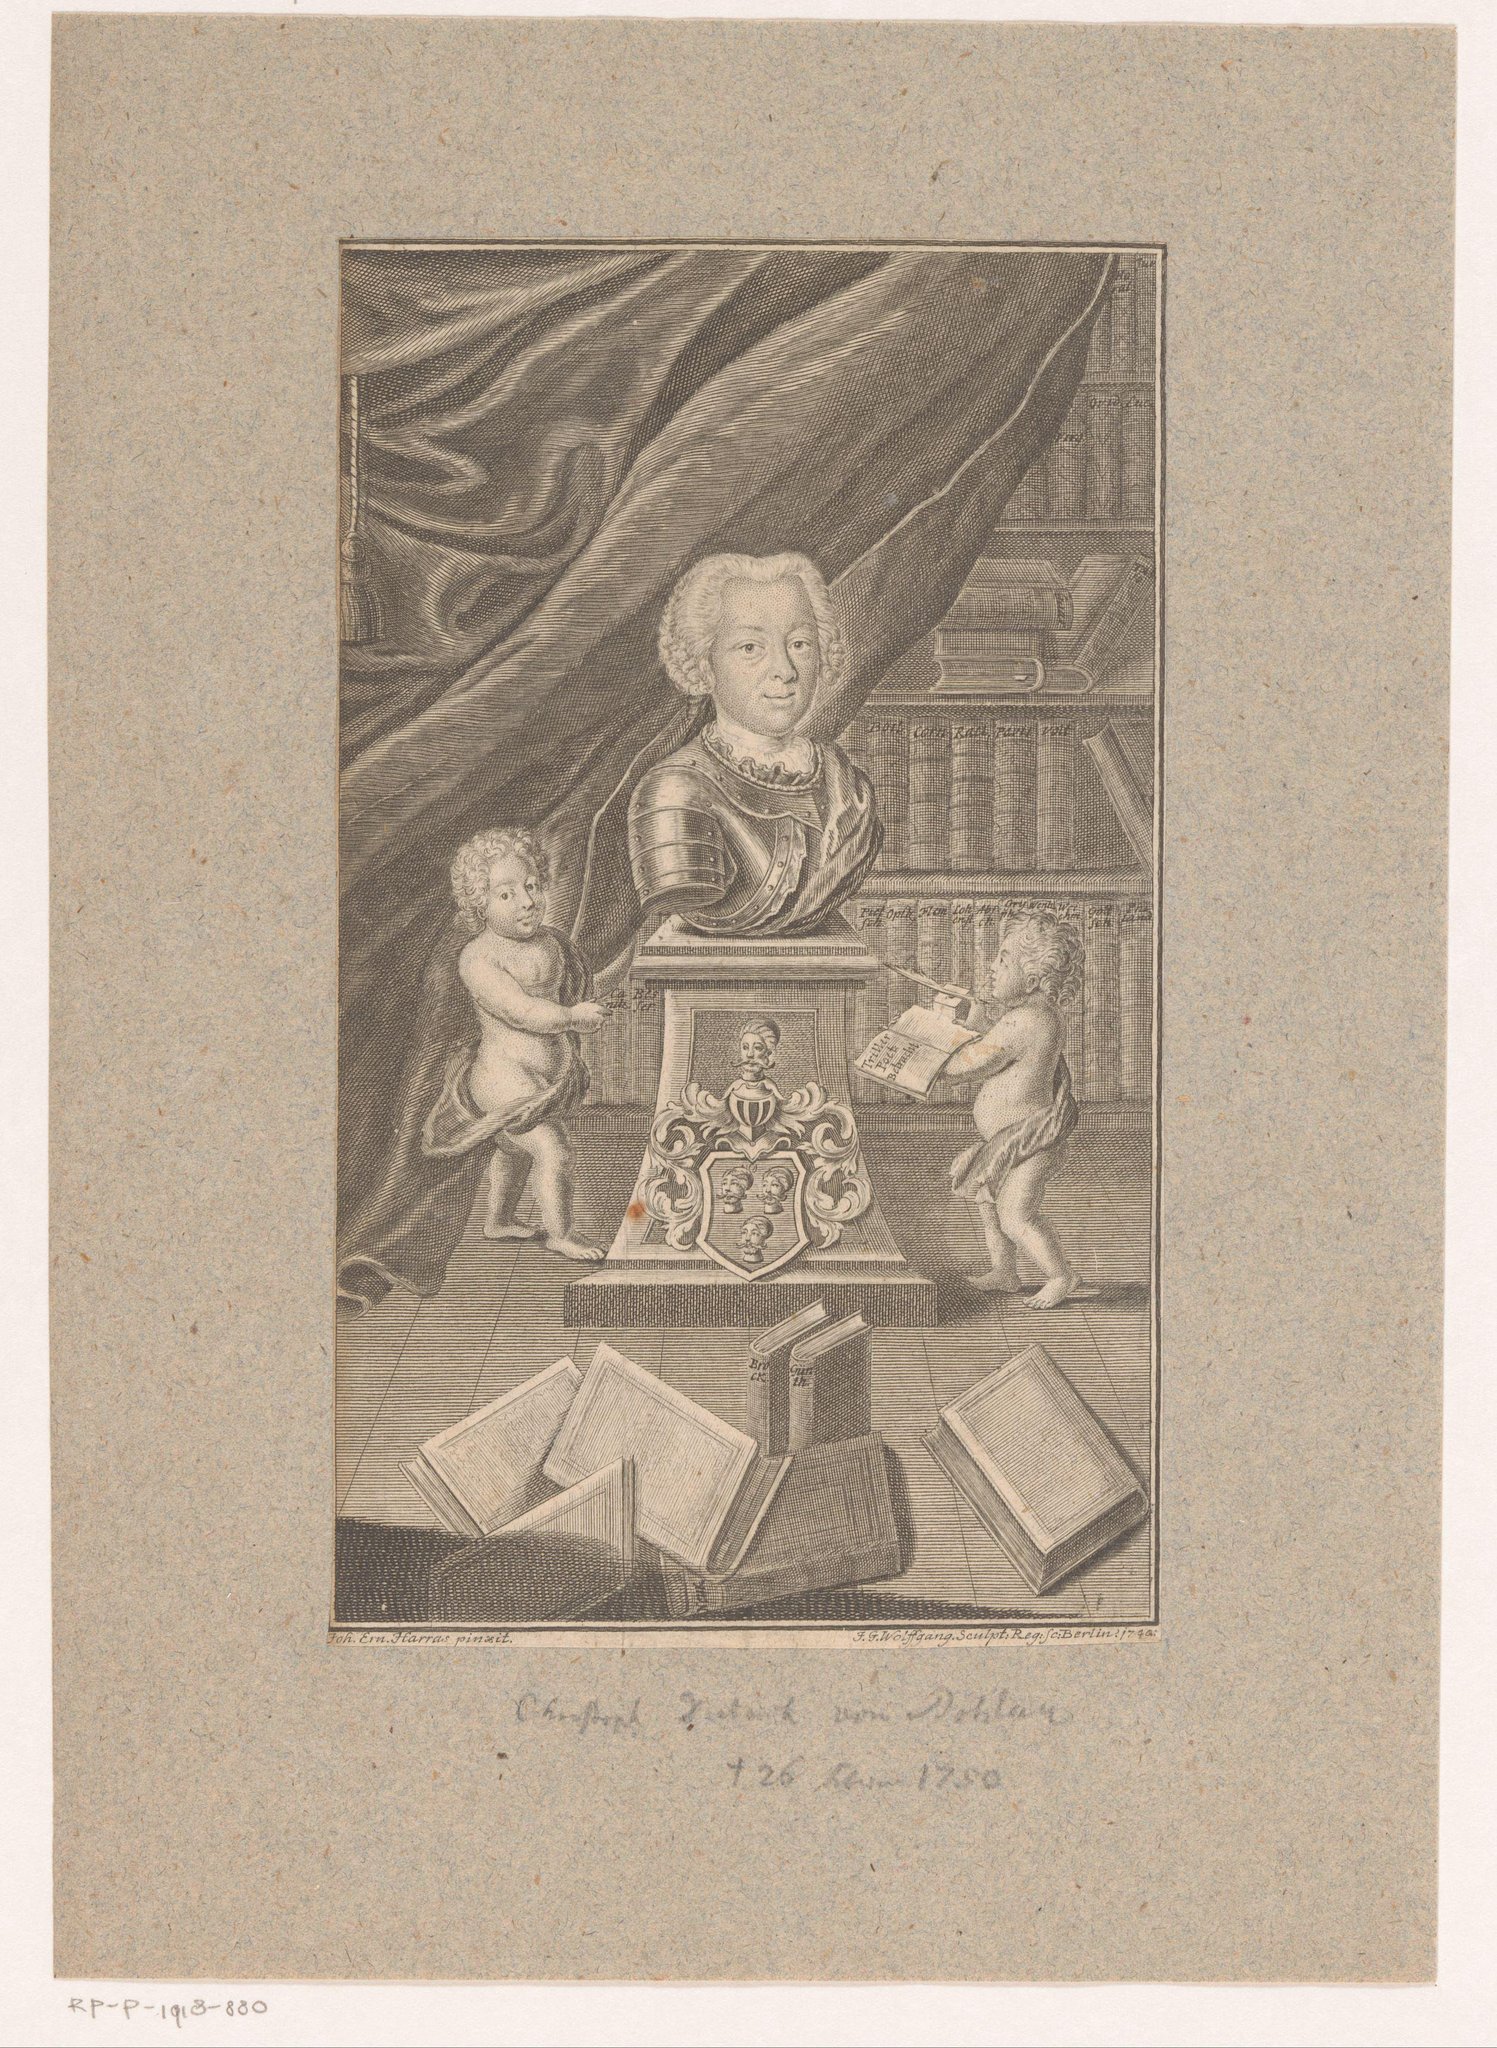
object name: print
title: Portret van Christoph Dietrich von Böhlau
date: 1740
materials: paper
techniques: engraving, etching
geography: berlin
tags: bookshelves, historical persons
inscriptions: collector's mark: Lugt 2233